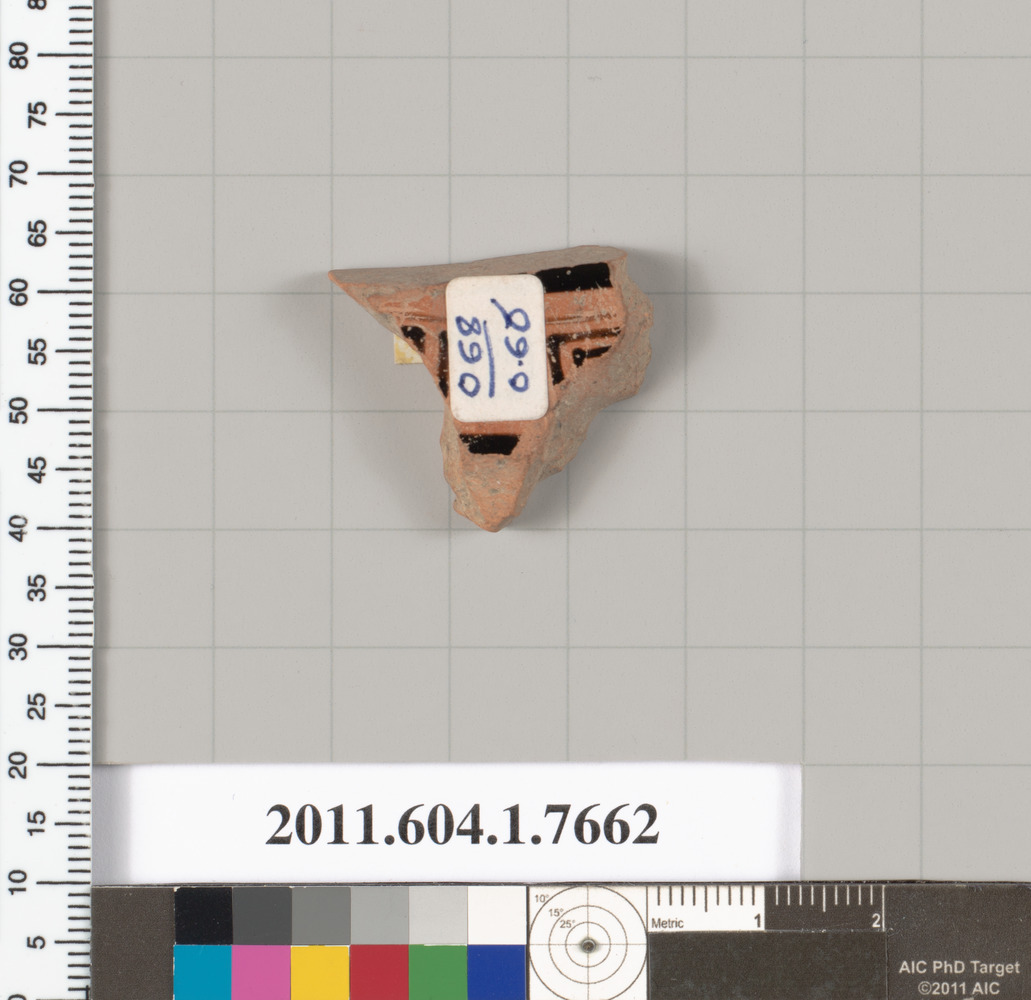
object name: kylix fragment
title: Terracotta fragment of a kylix (drinking cup)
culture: greek, attic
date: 460-450 BCE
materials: terracotta